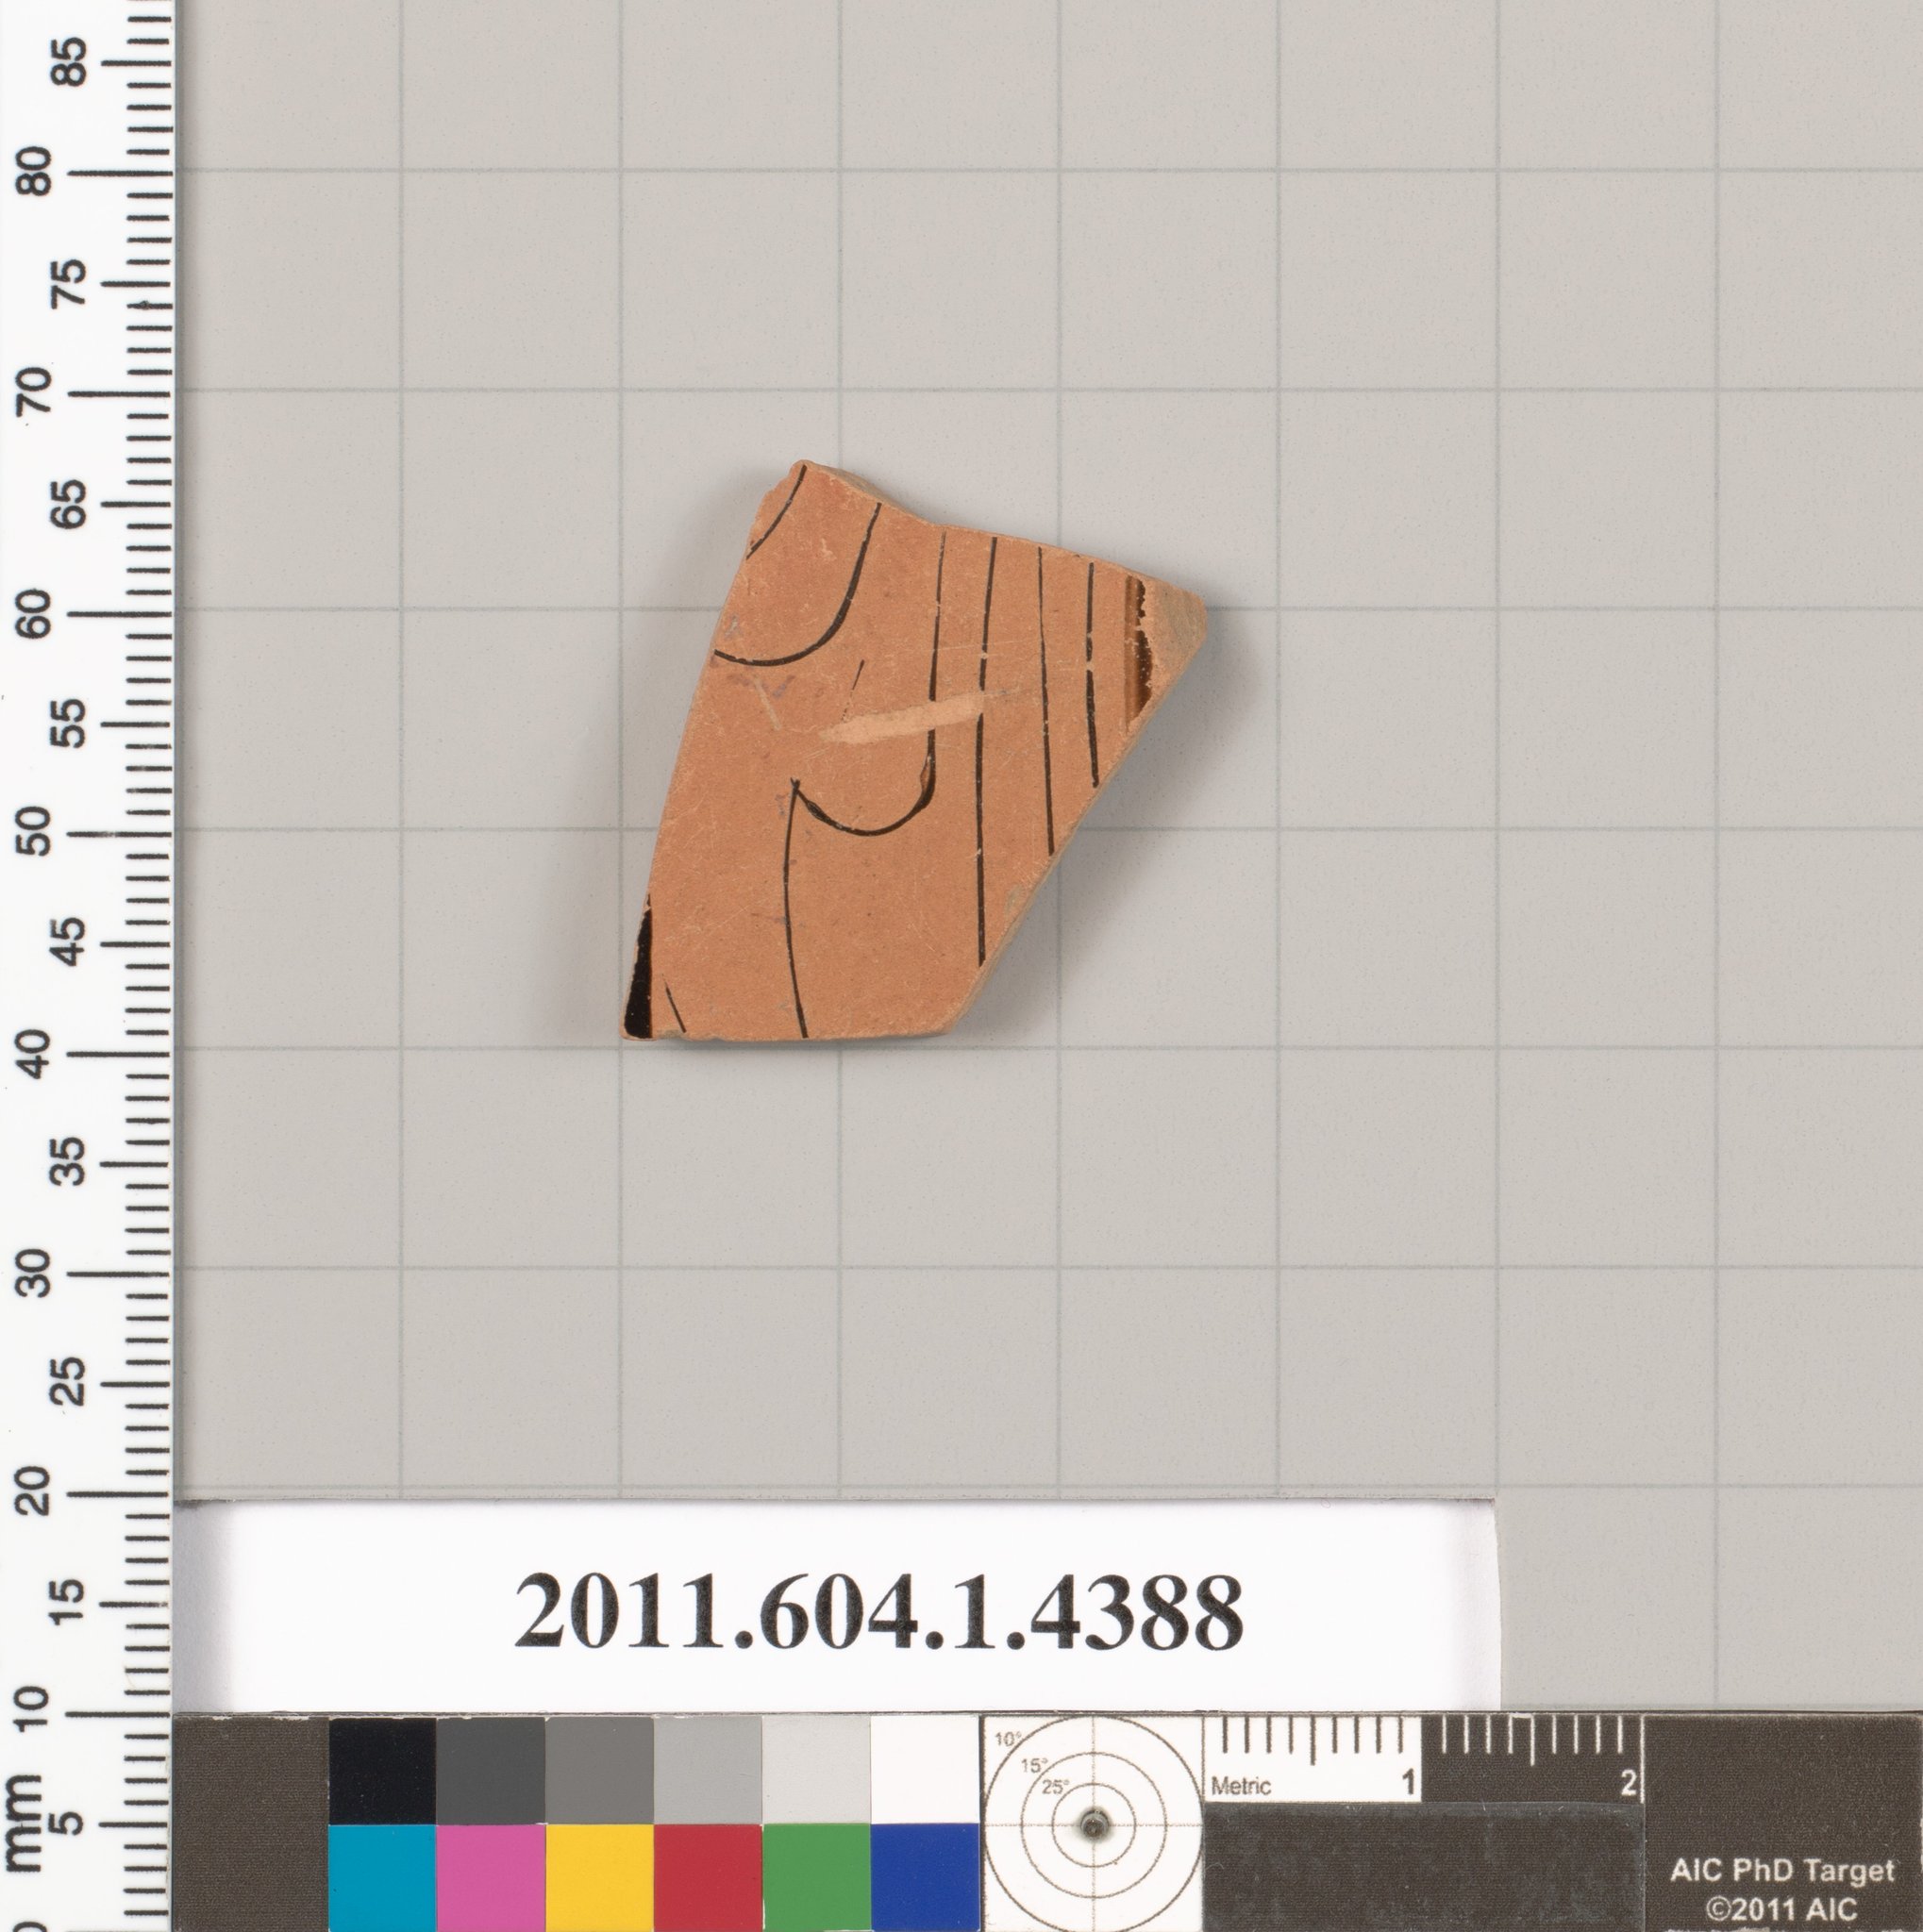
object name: kylix fragment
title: Terracotta fragment of a kylix (drinking cup)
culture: greek, attic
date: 475-451 BCE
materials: terracotta